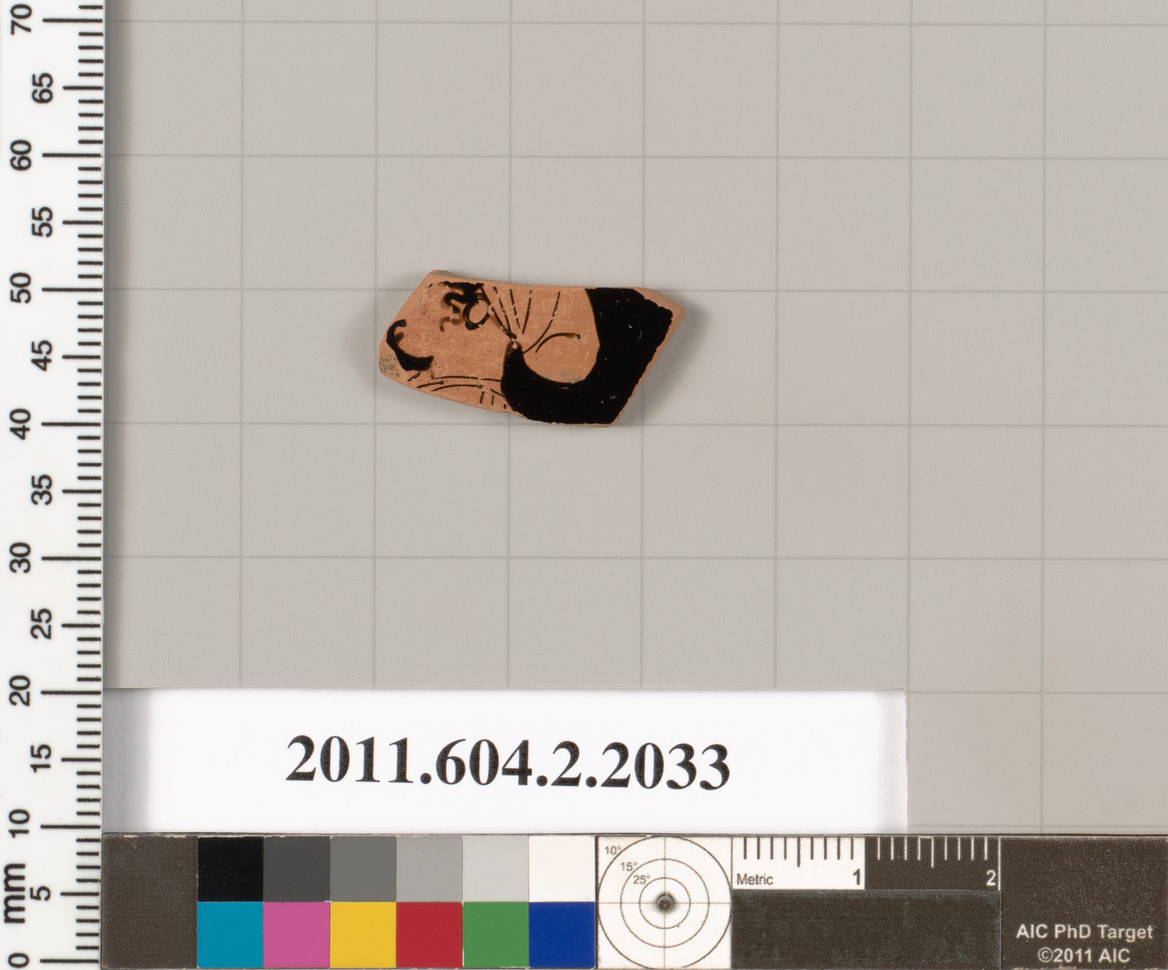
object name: pot fragment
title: Terracotta fragment of a pot; unglazed on the inside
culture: greek, attic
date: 475-451 BCE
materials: terracotta